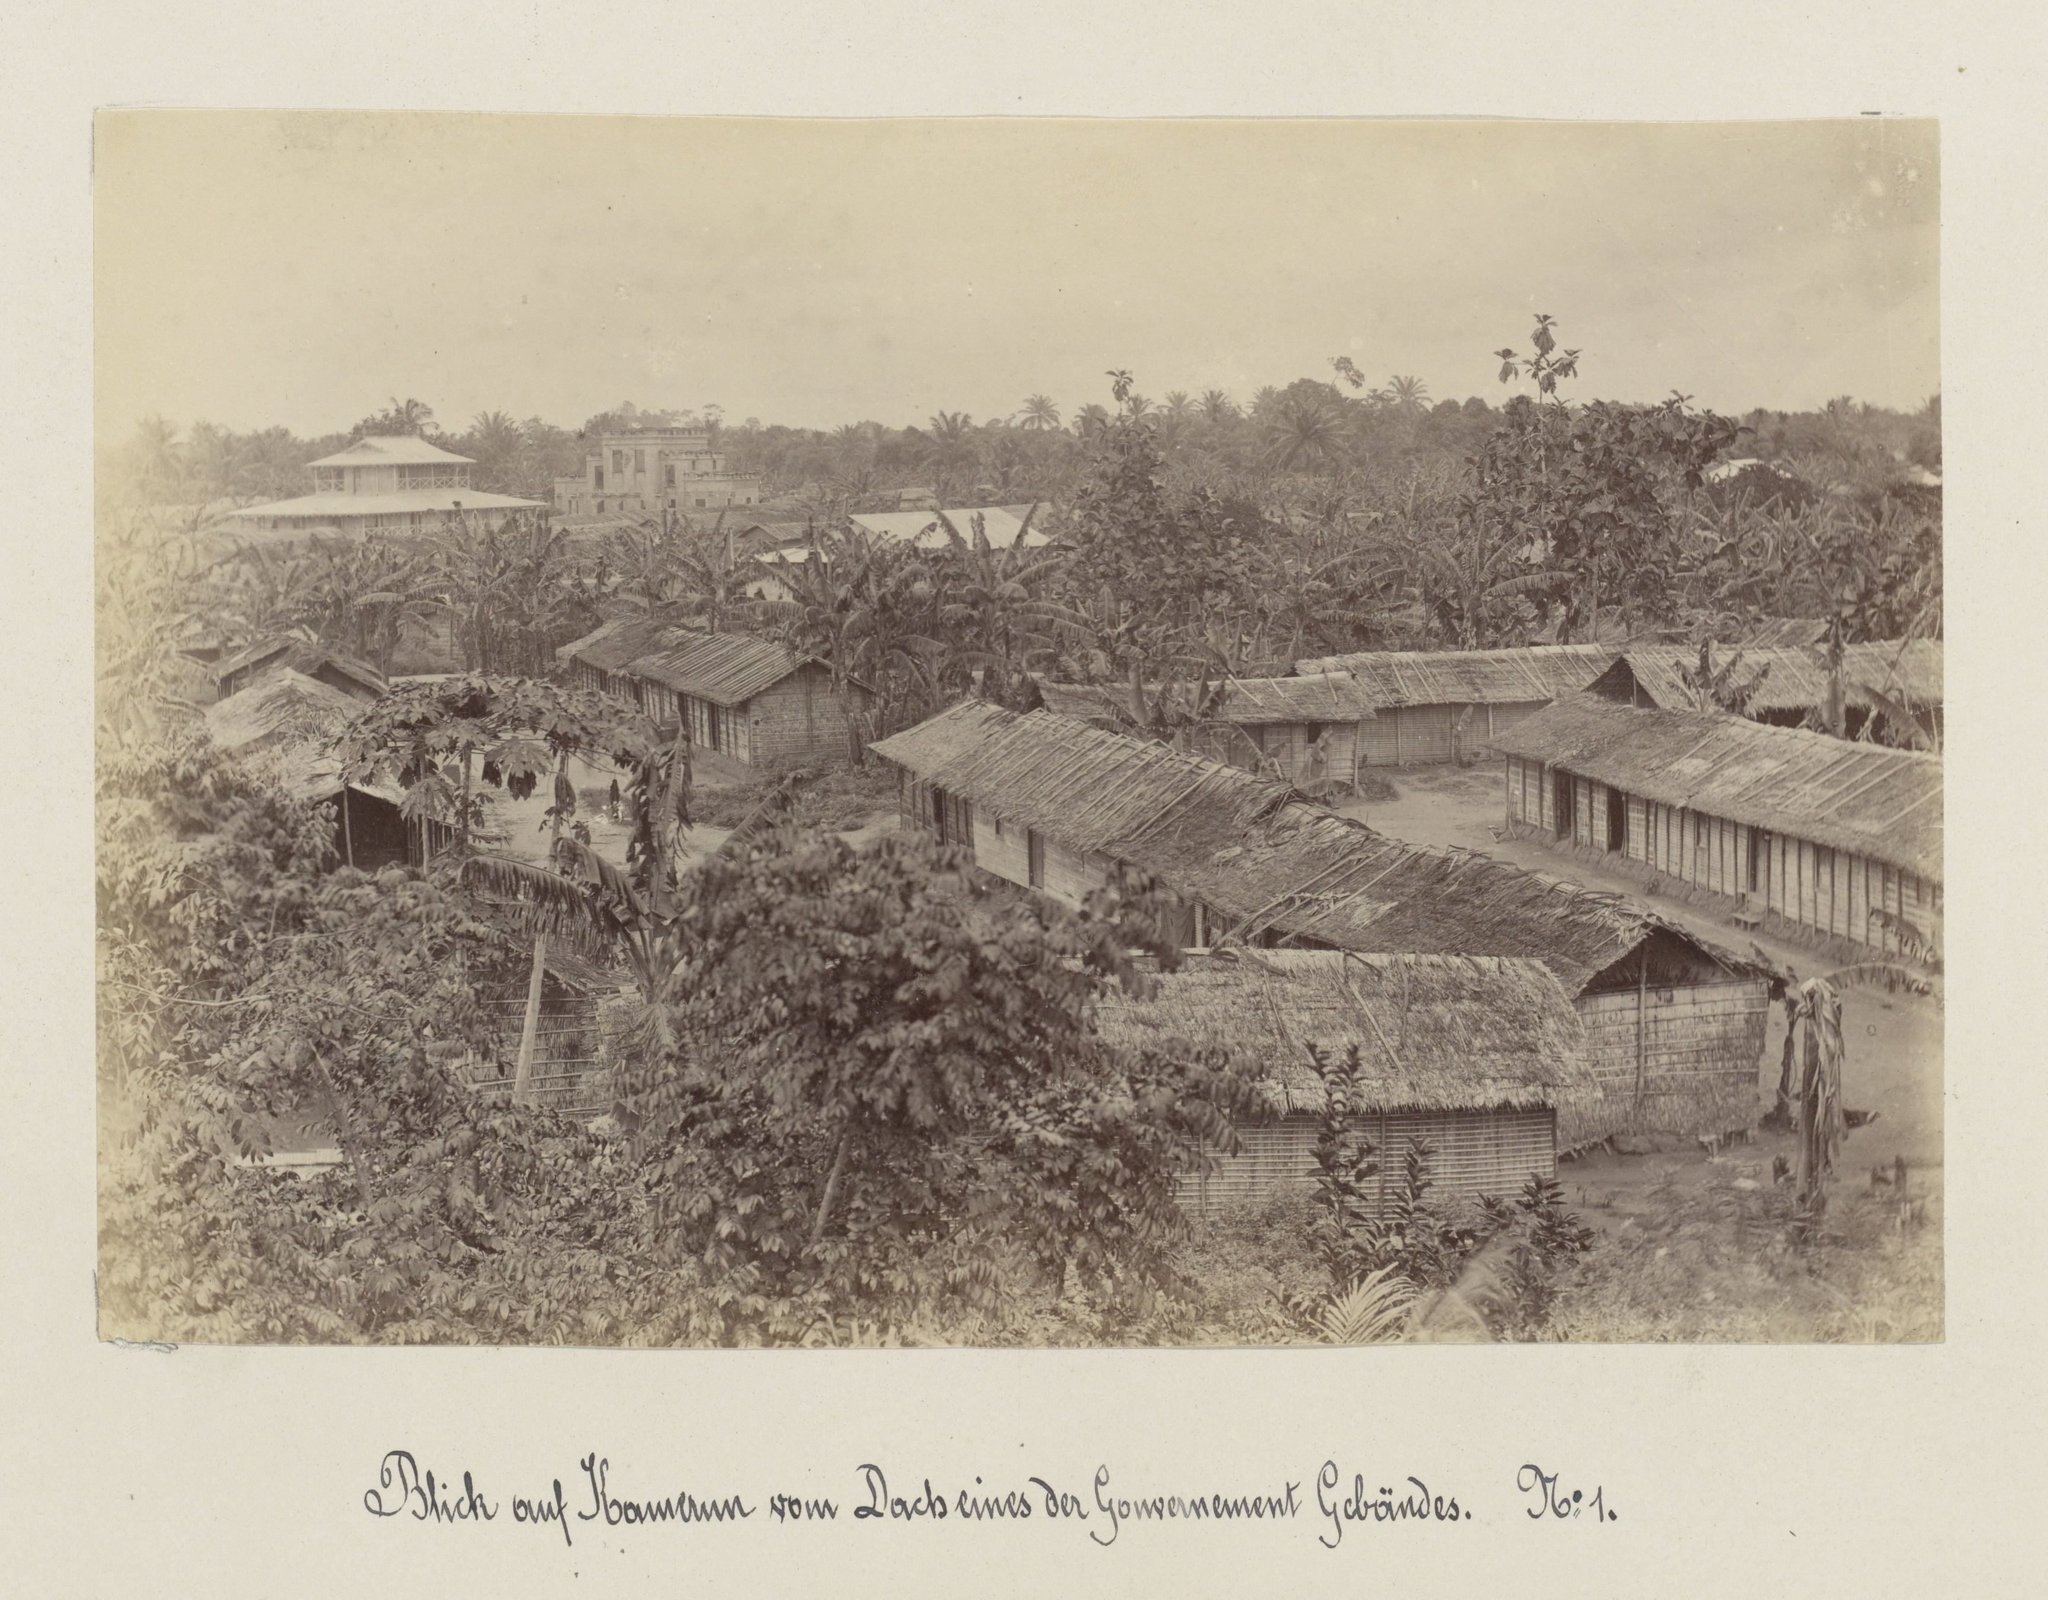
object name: photograph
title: Gezicht op de omgeving van een gouvernementsgebouw in Kameroen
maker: Anonymous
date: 1899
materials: photographic support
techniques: albumen print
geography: cameroon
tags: prospect of village, silhouette of village, forest, wood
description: Foto 1 van een panorama van 4. Onderdeel van Fotoalbum met opnames van Kameroen rond 1899.